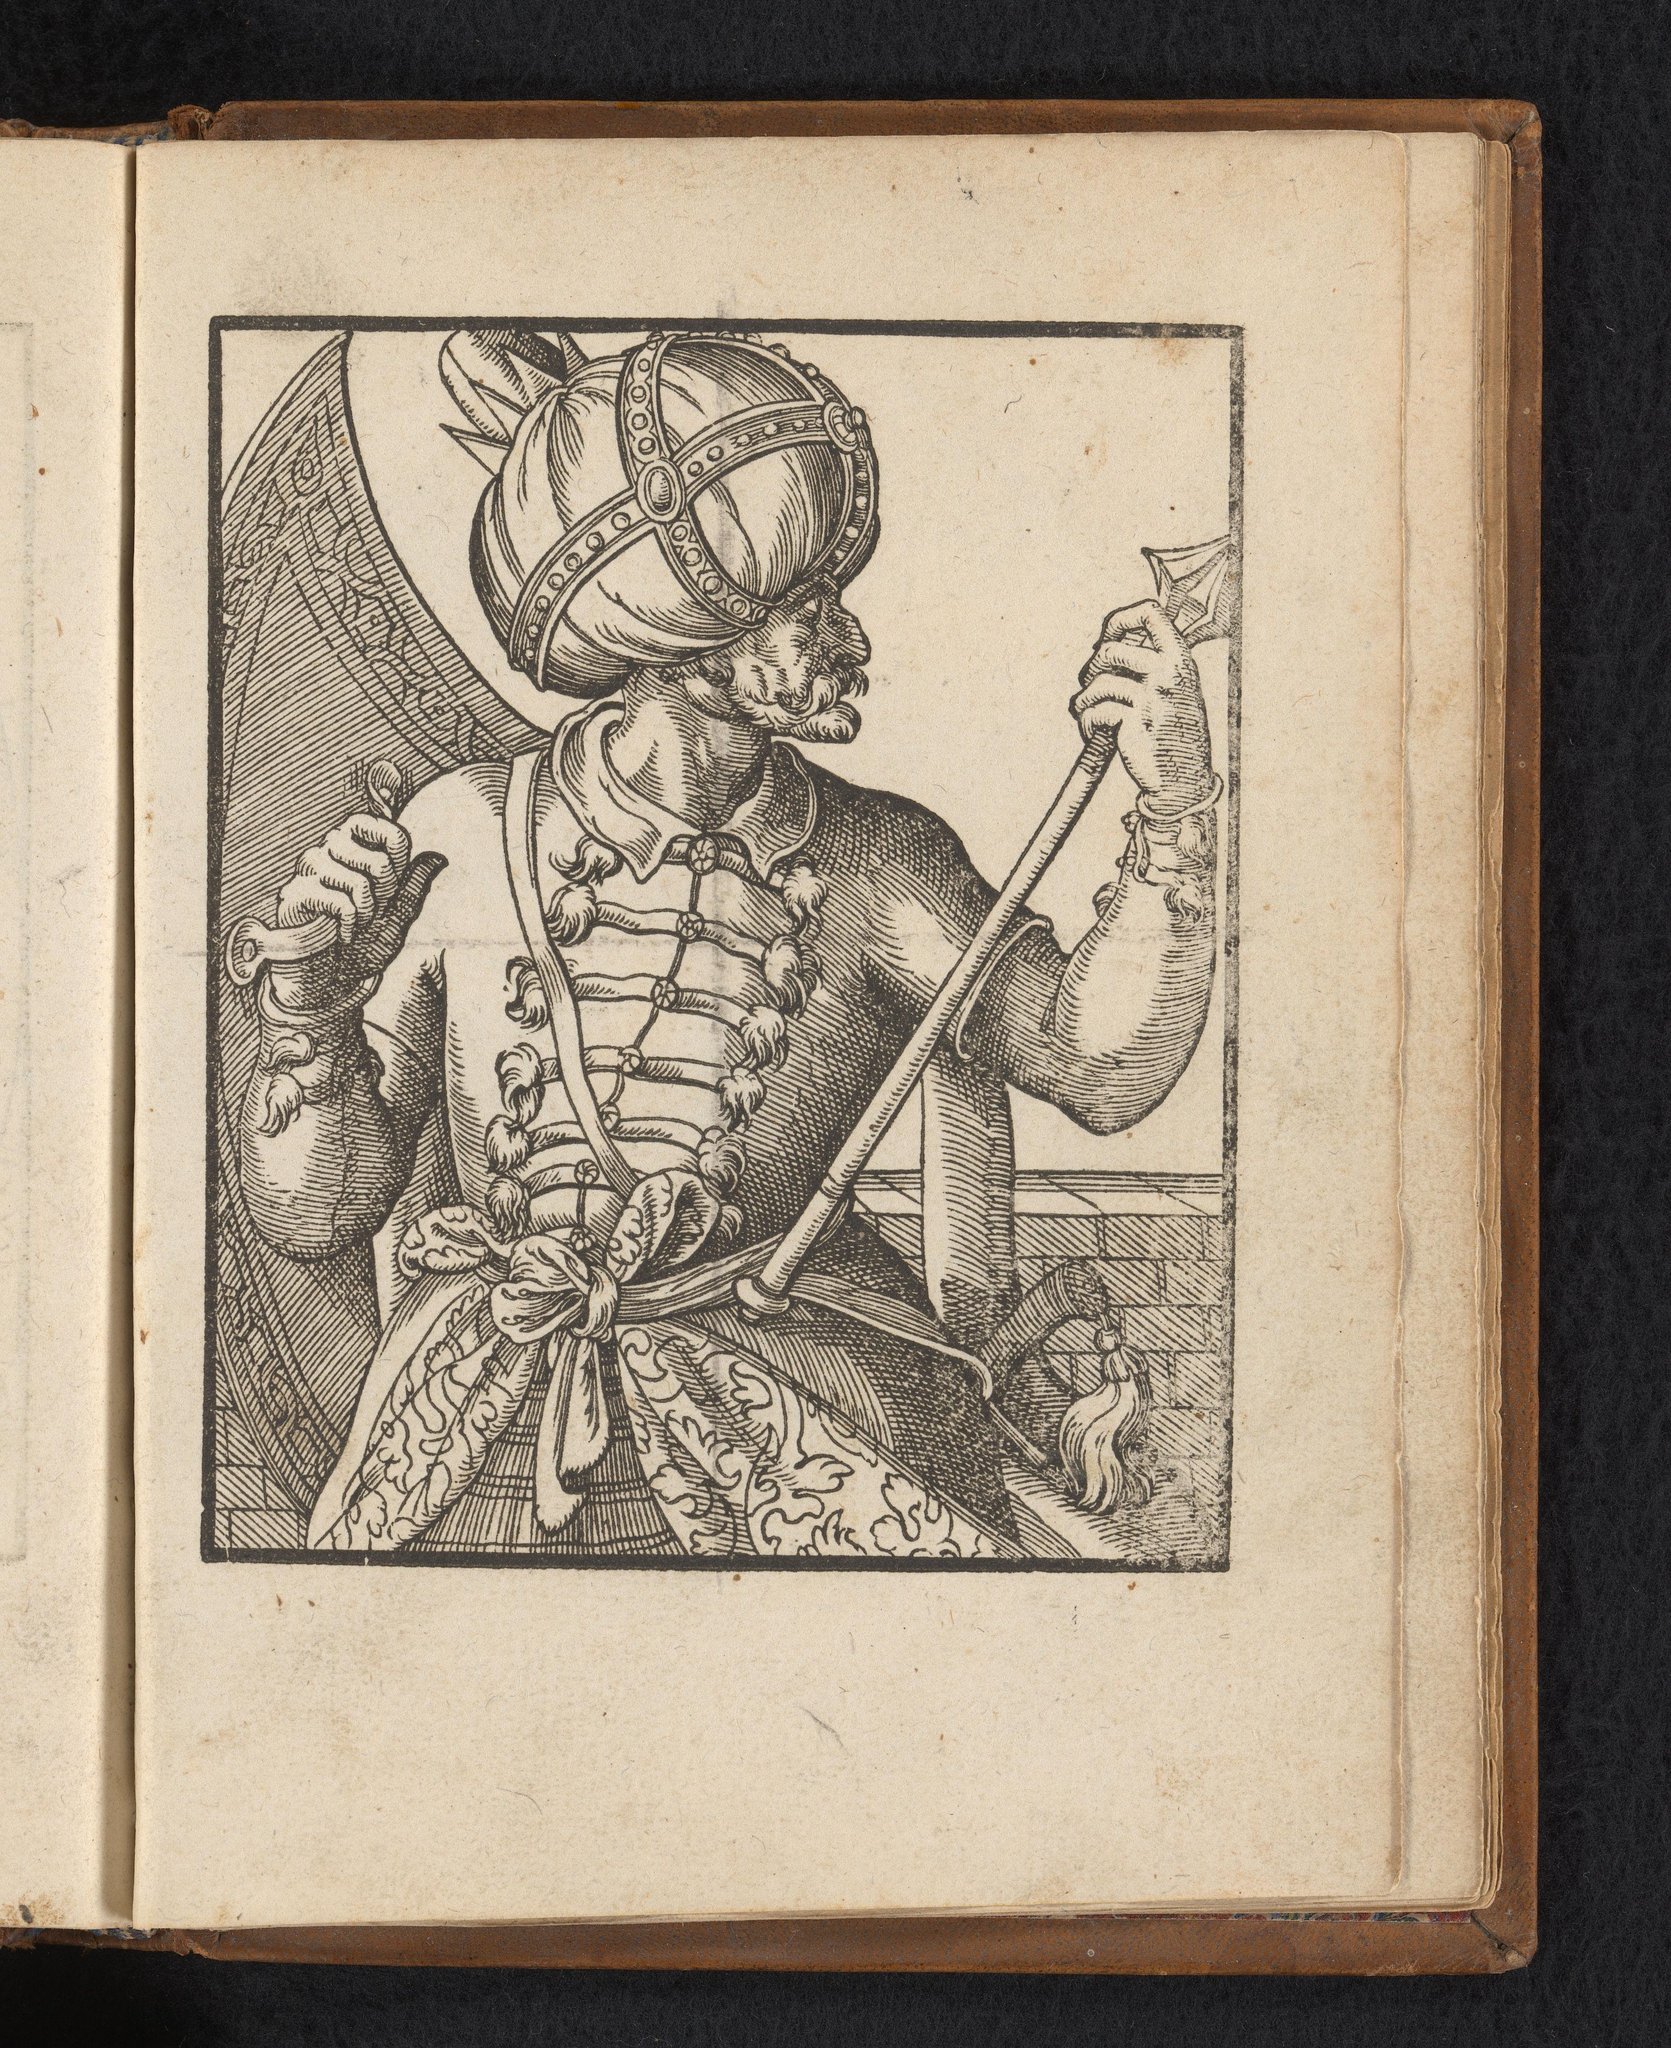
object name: print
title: Ottomaanse veldheer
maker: Anonymous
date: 1578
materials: paper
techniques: woodcut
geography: nuremberg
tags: asiatic races and peoples: turks, head-gear: turban, the soldier; the soldier's life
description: Een Ottomaanse veldheer, naar rechts, in de handen een schild en een strijdknots, op het hoofd een tulband. Onderdeel van het modelboek Enchiridion artis pingendi, fingendi & sculpendi met 108 figuren bedoeld voor beginnende schilders, beeldhouwers en prentmakers.